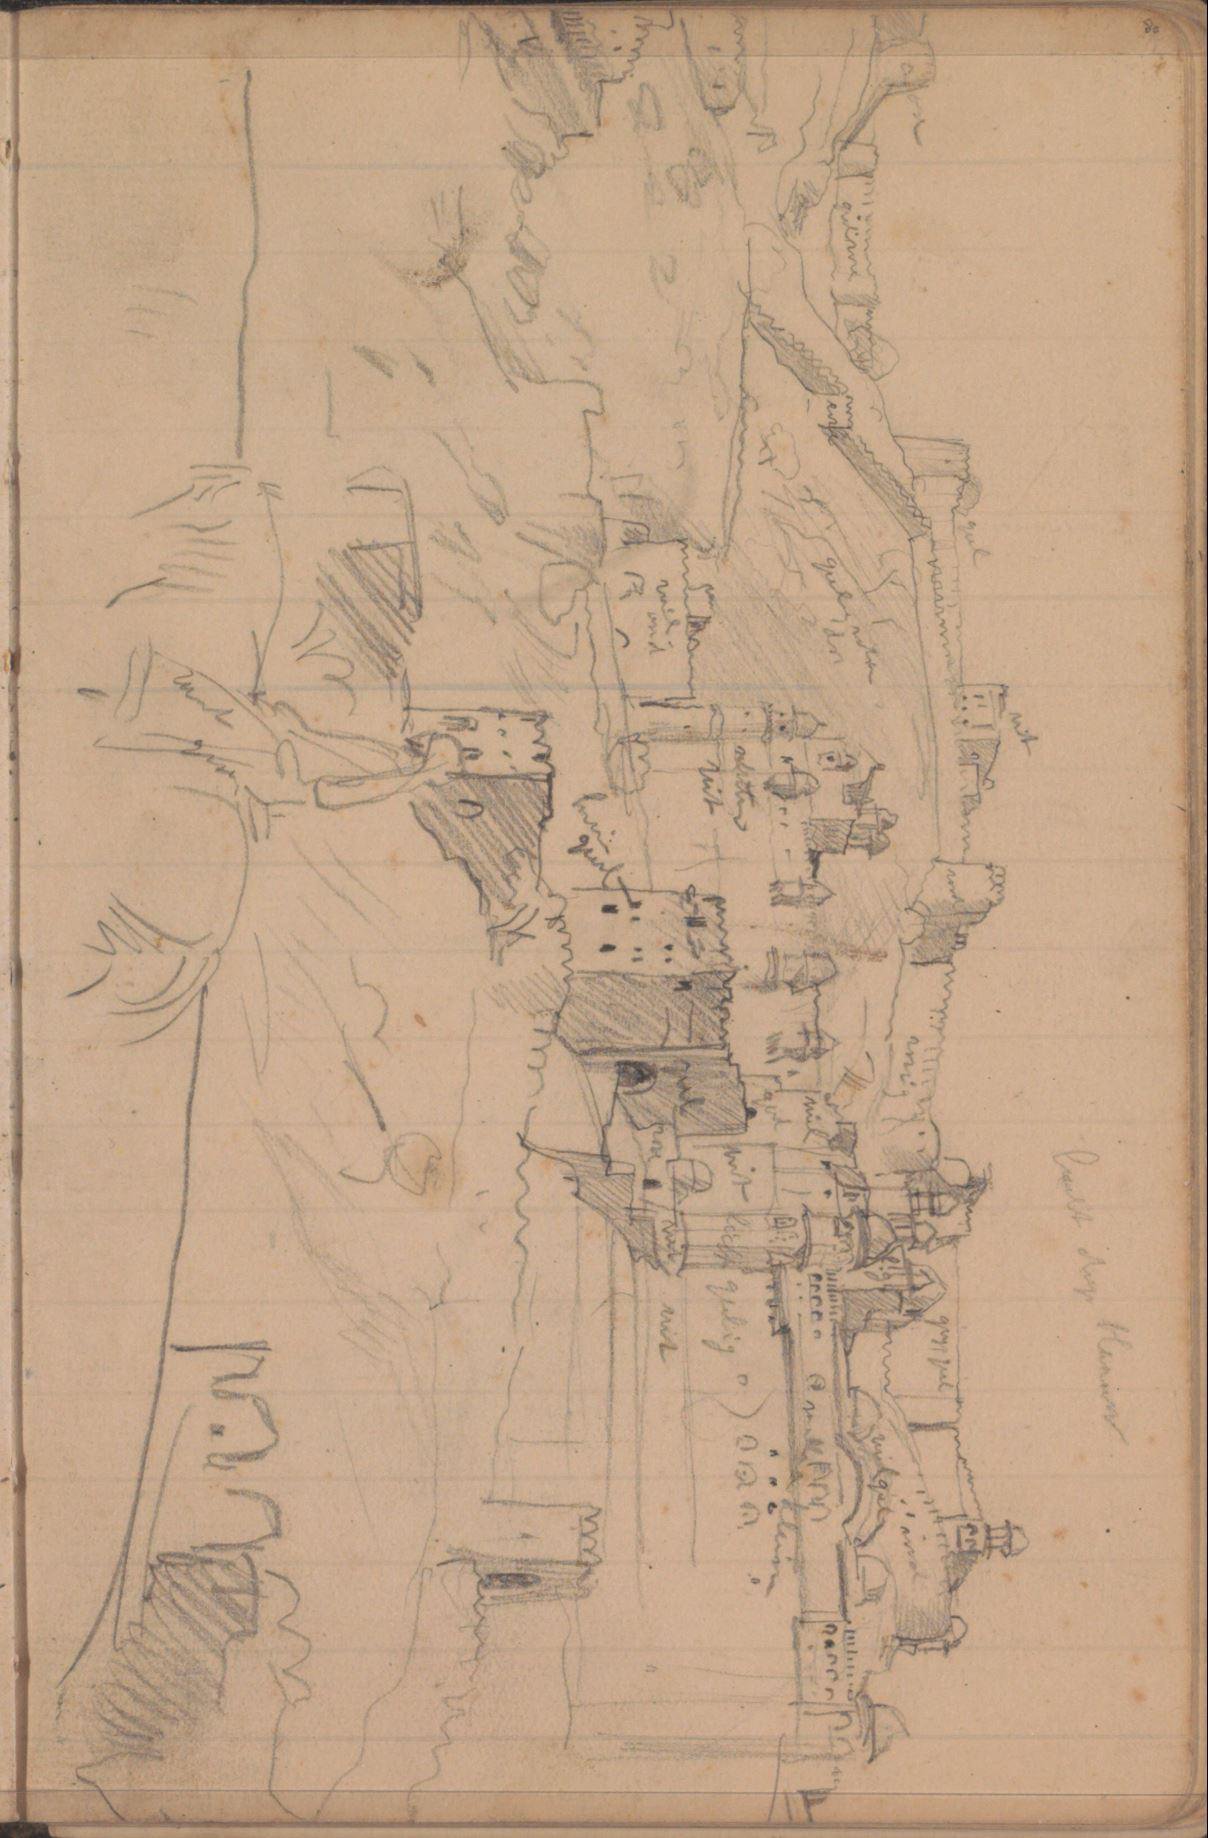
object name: sketchbook leaf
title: Gezicht op Amber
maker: marius bauer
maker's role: draughtsman, print maker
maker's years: 1867-1932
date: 1897-1898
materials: pencil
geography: amber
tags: city-view, and landscape with man-made constructions, walls ~ fortified city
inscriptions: kleurnotitie, handgeschreven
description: Pagina 80 uit een schetsboek met 84 bladen.